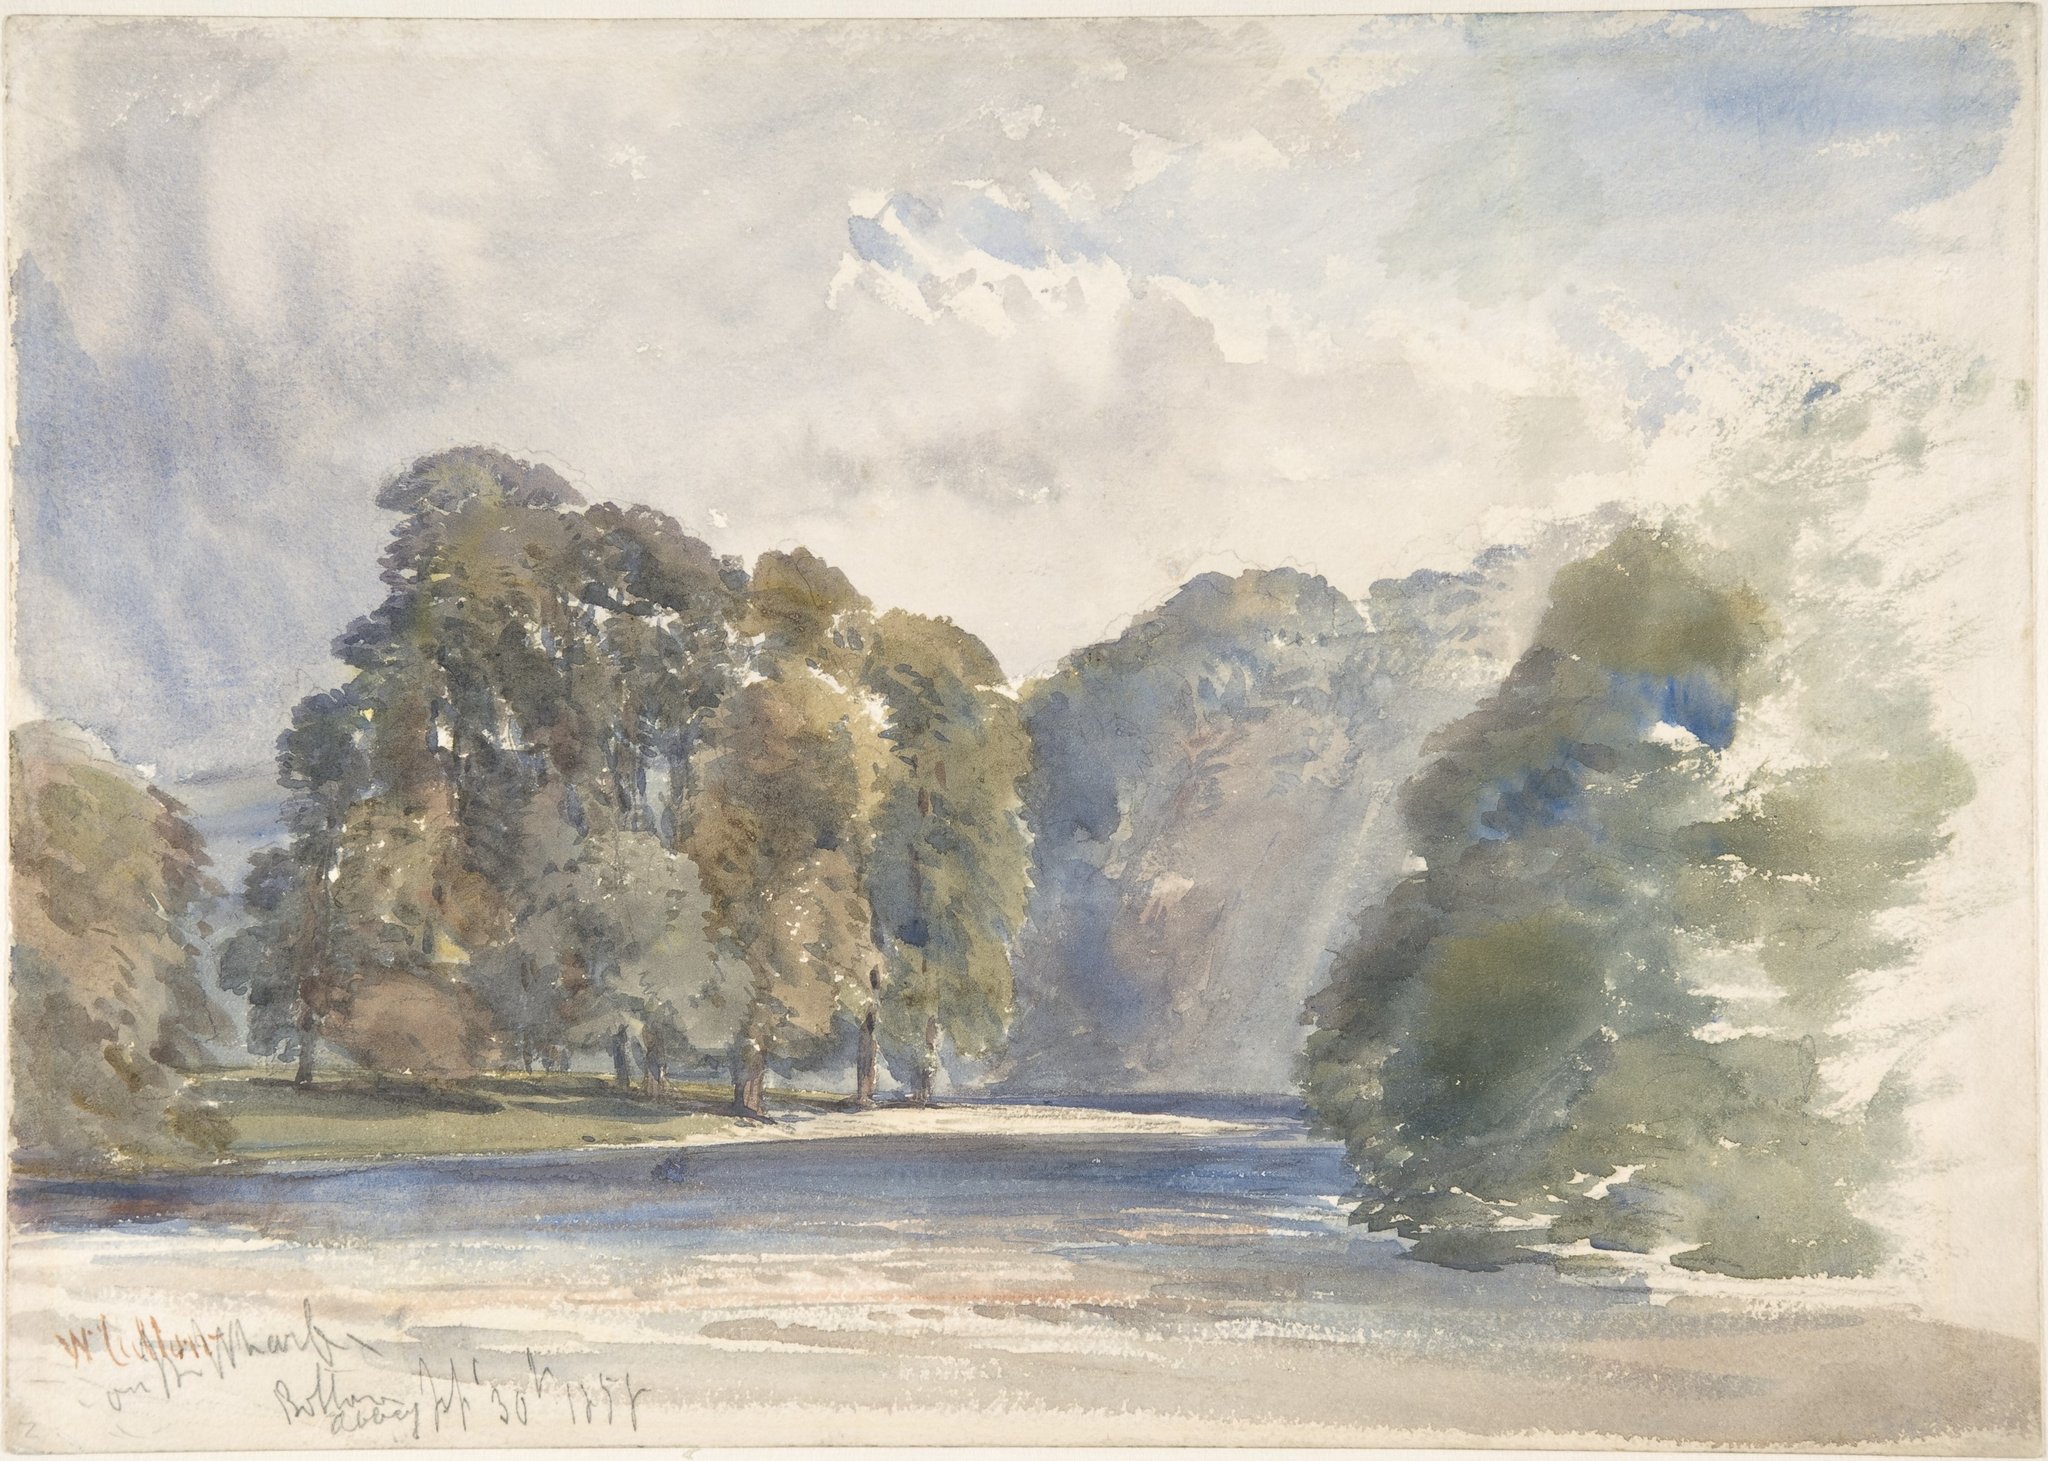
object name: drawing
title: On the Wharfe, Bolton Abbey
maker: william callow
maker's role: artist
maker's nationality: british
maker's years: 1812-1908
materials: watercolor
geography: united kingdom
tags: landscapes